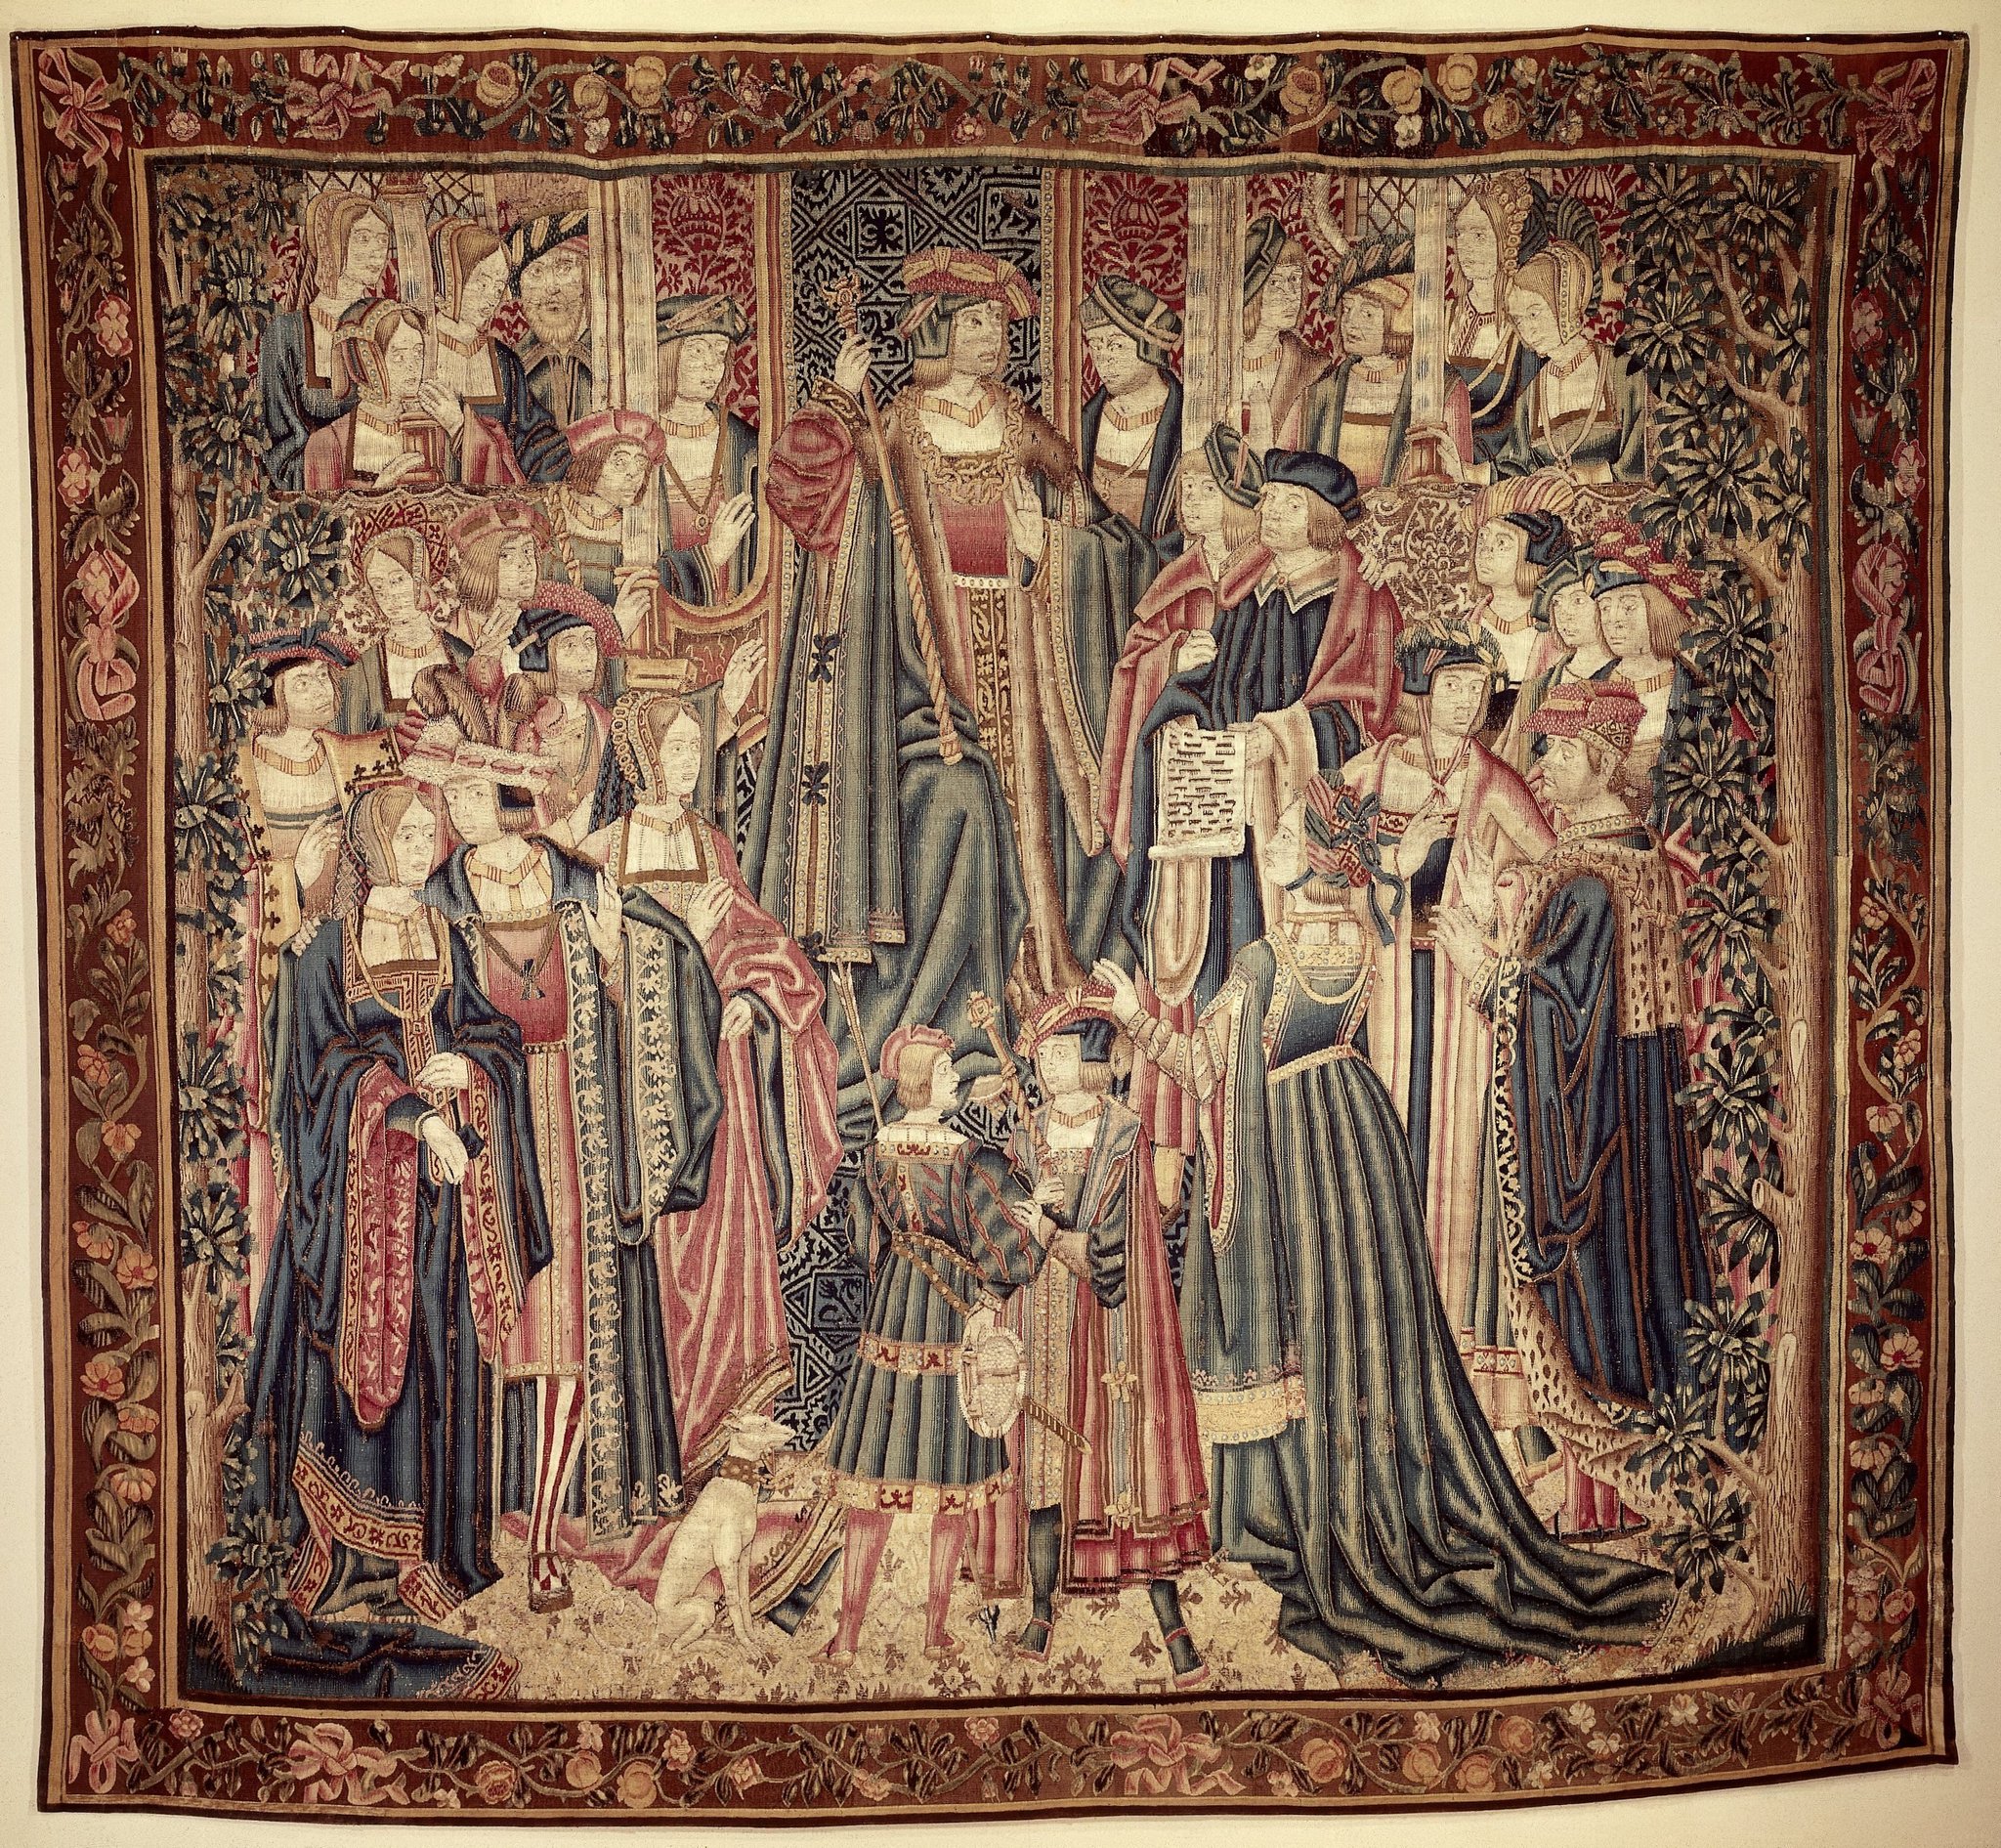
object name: tapestry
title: Hofscène met een vorst op de troon, omringd door hovelingen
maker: Anonymous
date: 1500-1525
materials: wool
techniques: tapestry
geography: southern netherlands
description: Hofscène met een vorst op de troon, omringd door hovelingen.